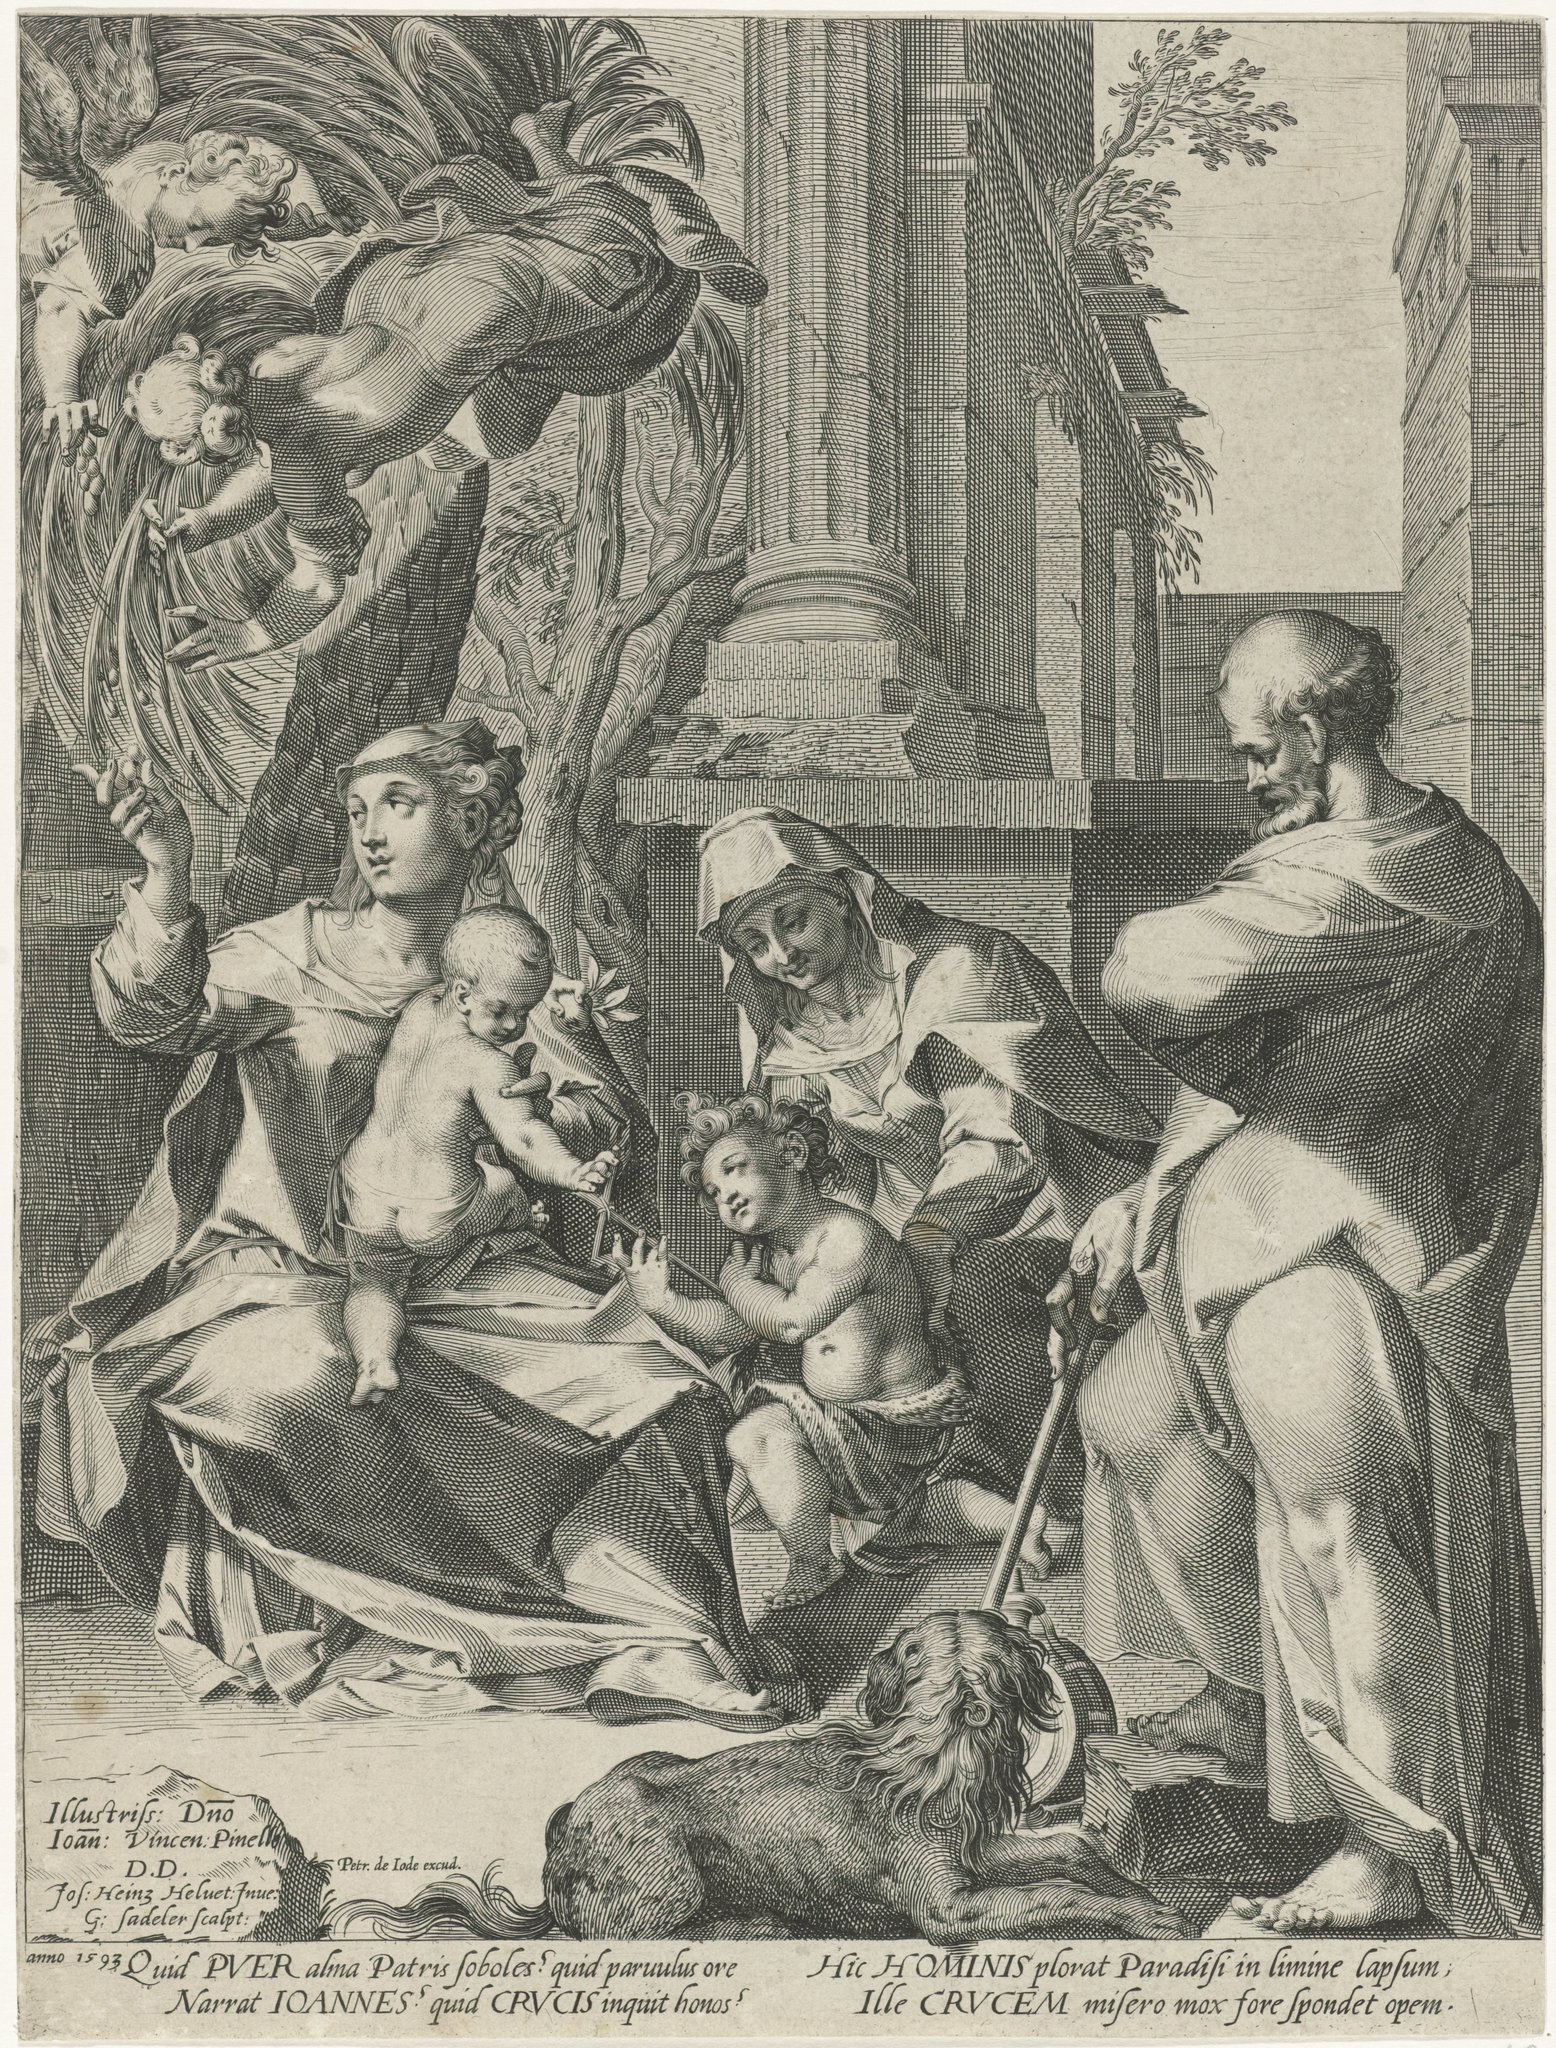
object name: print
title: Heilige familie met Elisabet en Johannes de Doper als kind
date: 1593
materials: paper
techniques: engraving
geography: italy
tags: holy family with john the baptist, elisabeth present (+ angel(s))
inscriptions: collector's mark: Lugt 240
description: De heilige familie met Elisabet en Johannes de Doper als kind. Twee engelen in de lucht brengen Maria en het Christuskind fruit en voorzien hen van schaduw. De prent heeft een Latijns onderschrift.